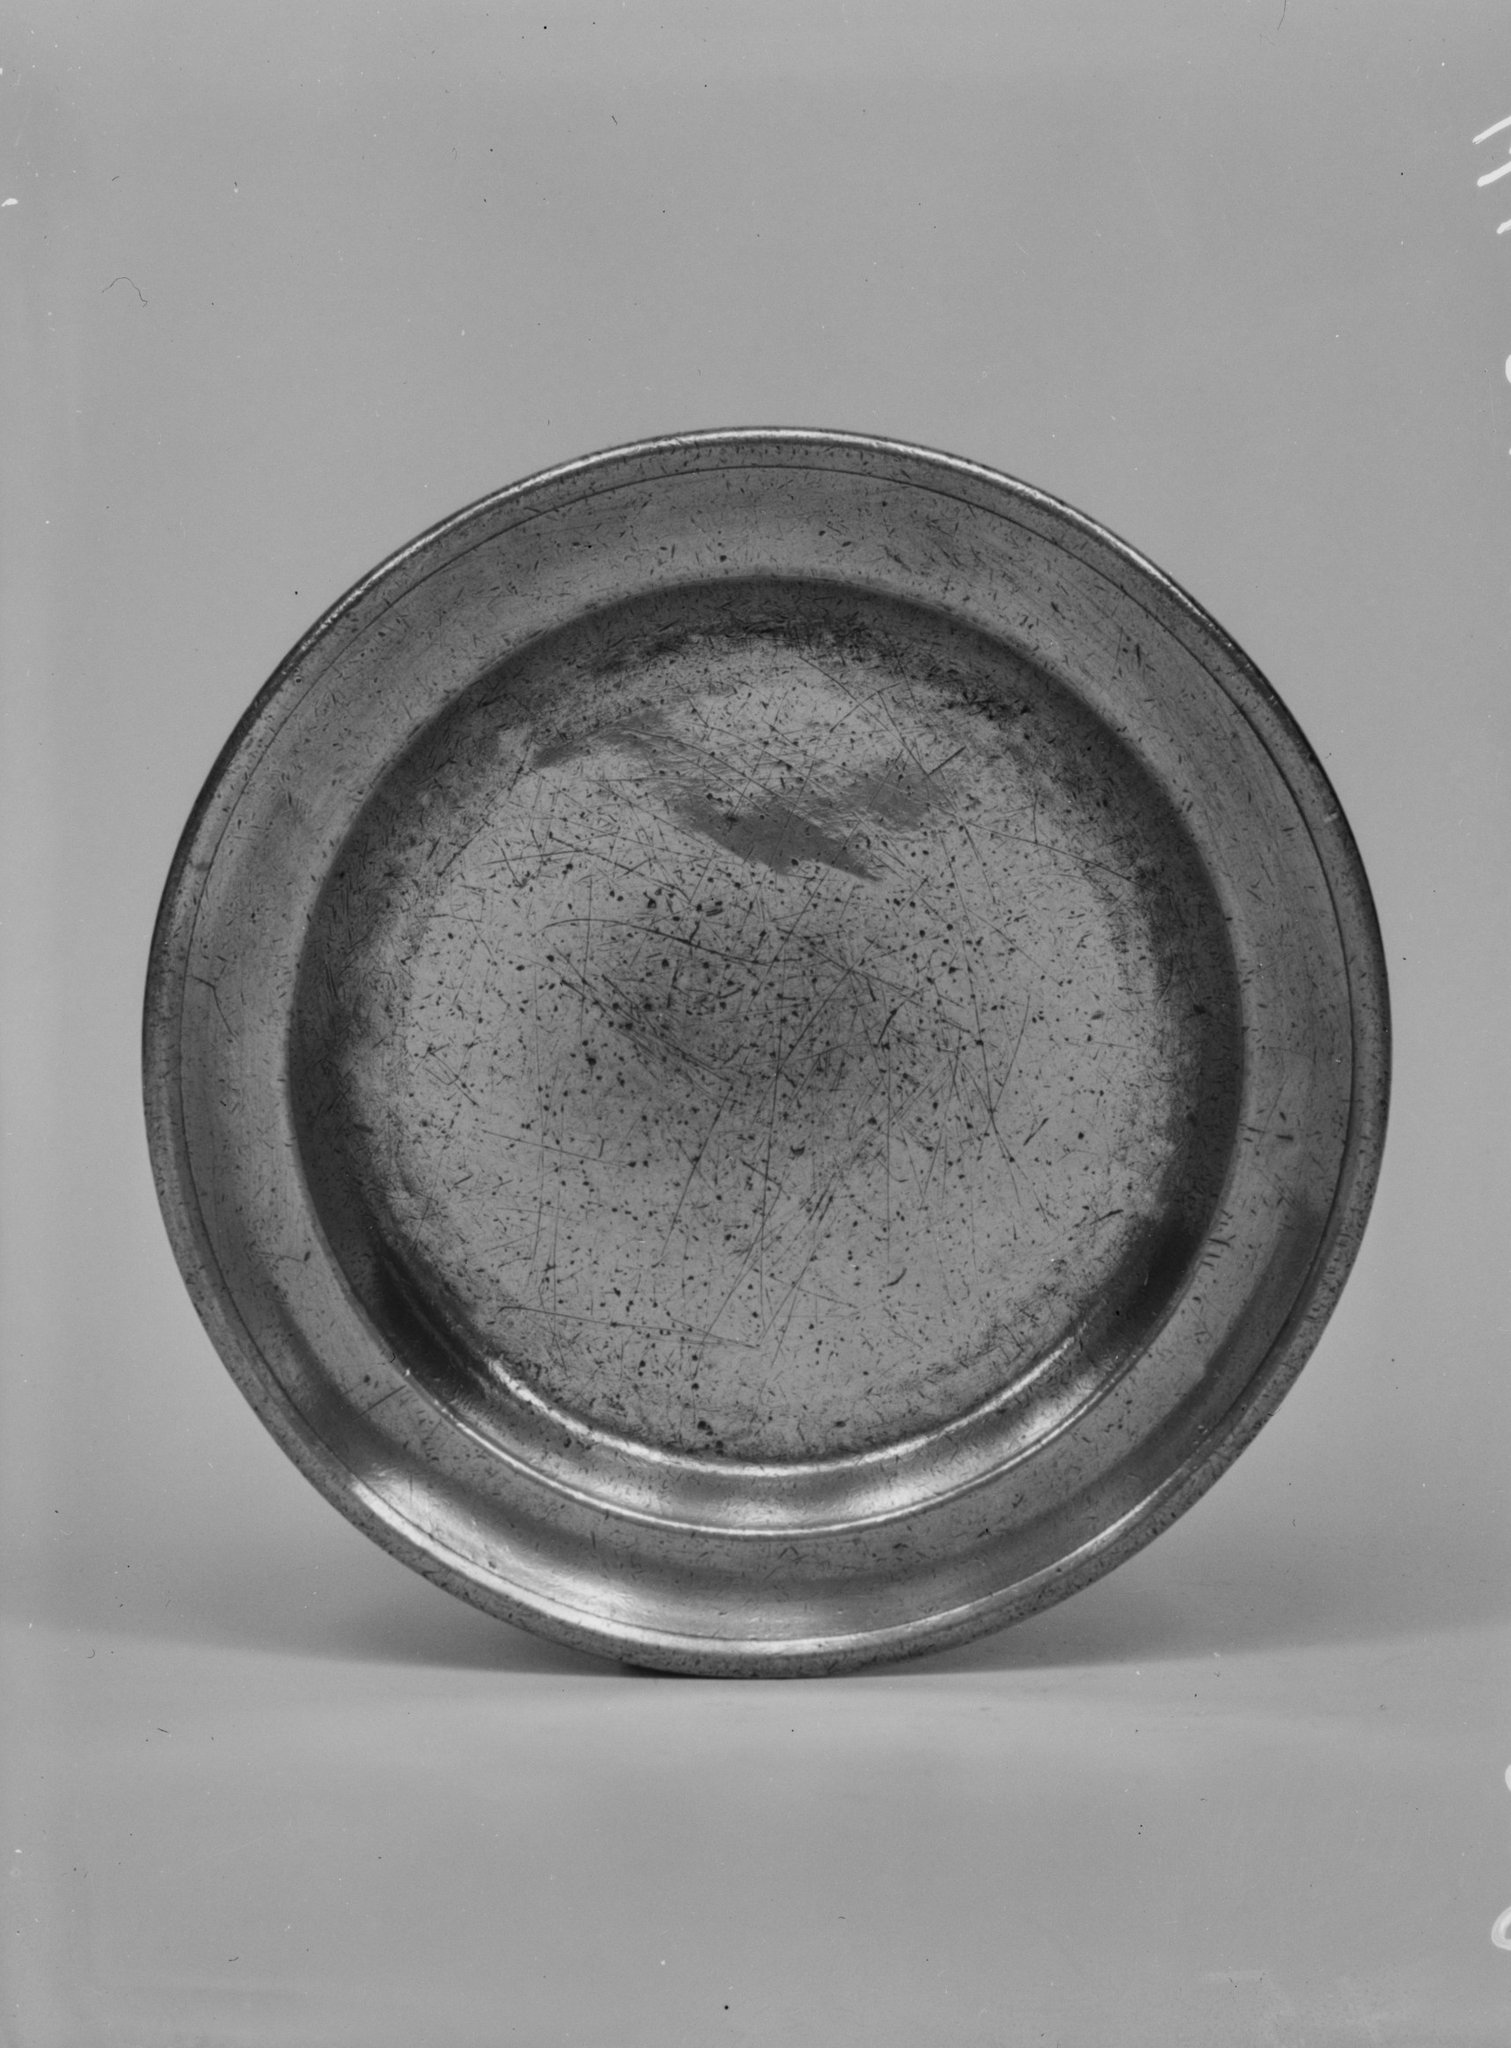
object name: plate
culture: american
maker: blakeslee barnes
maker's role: maker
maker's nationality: american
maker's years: 1781-1823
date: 1812-1817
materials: pewter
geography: united states